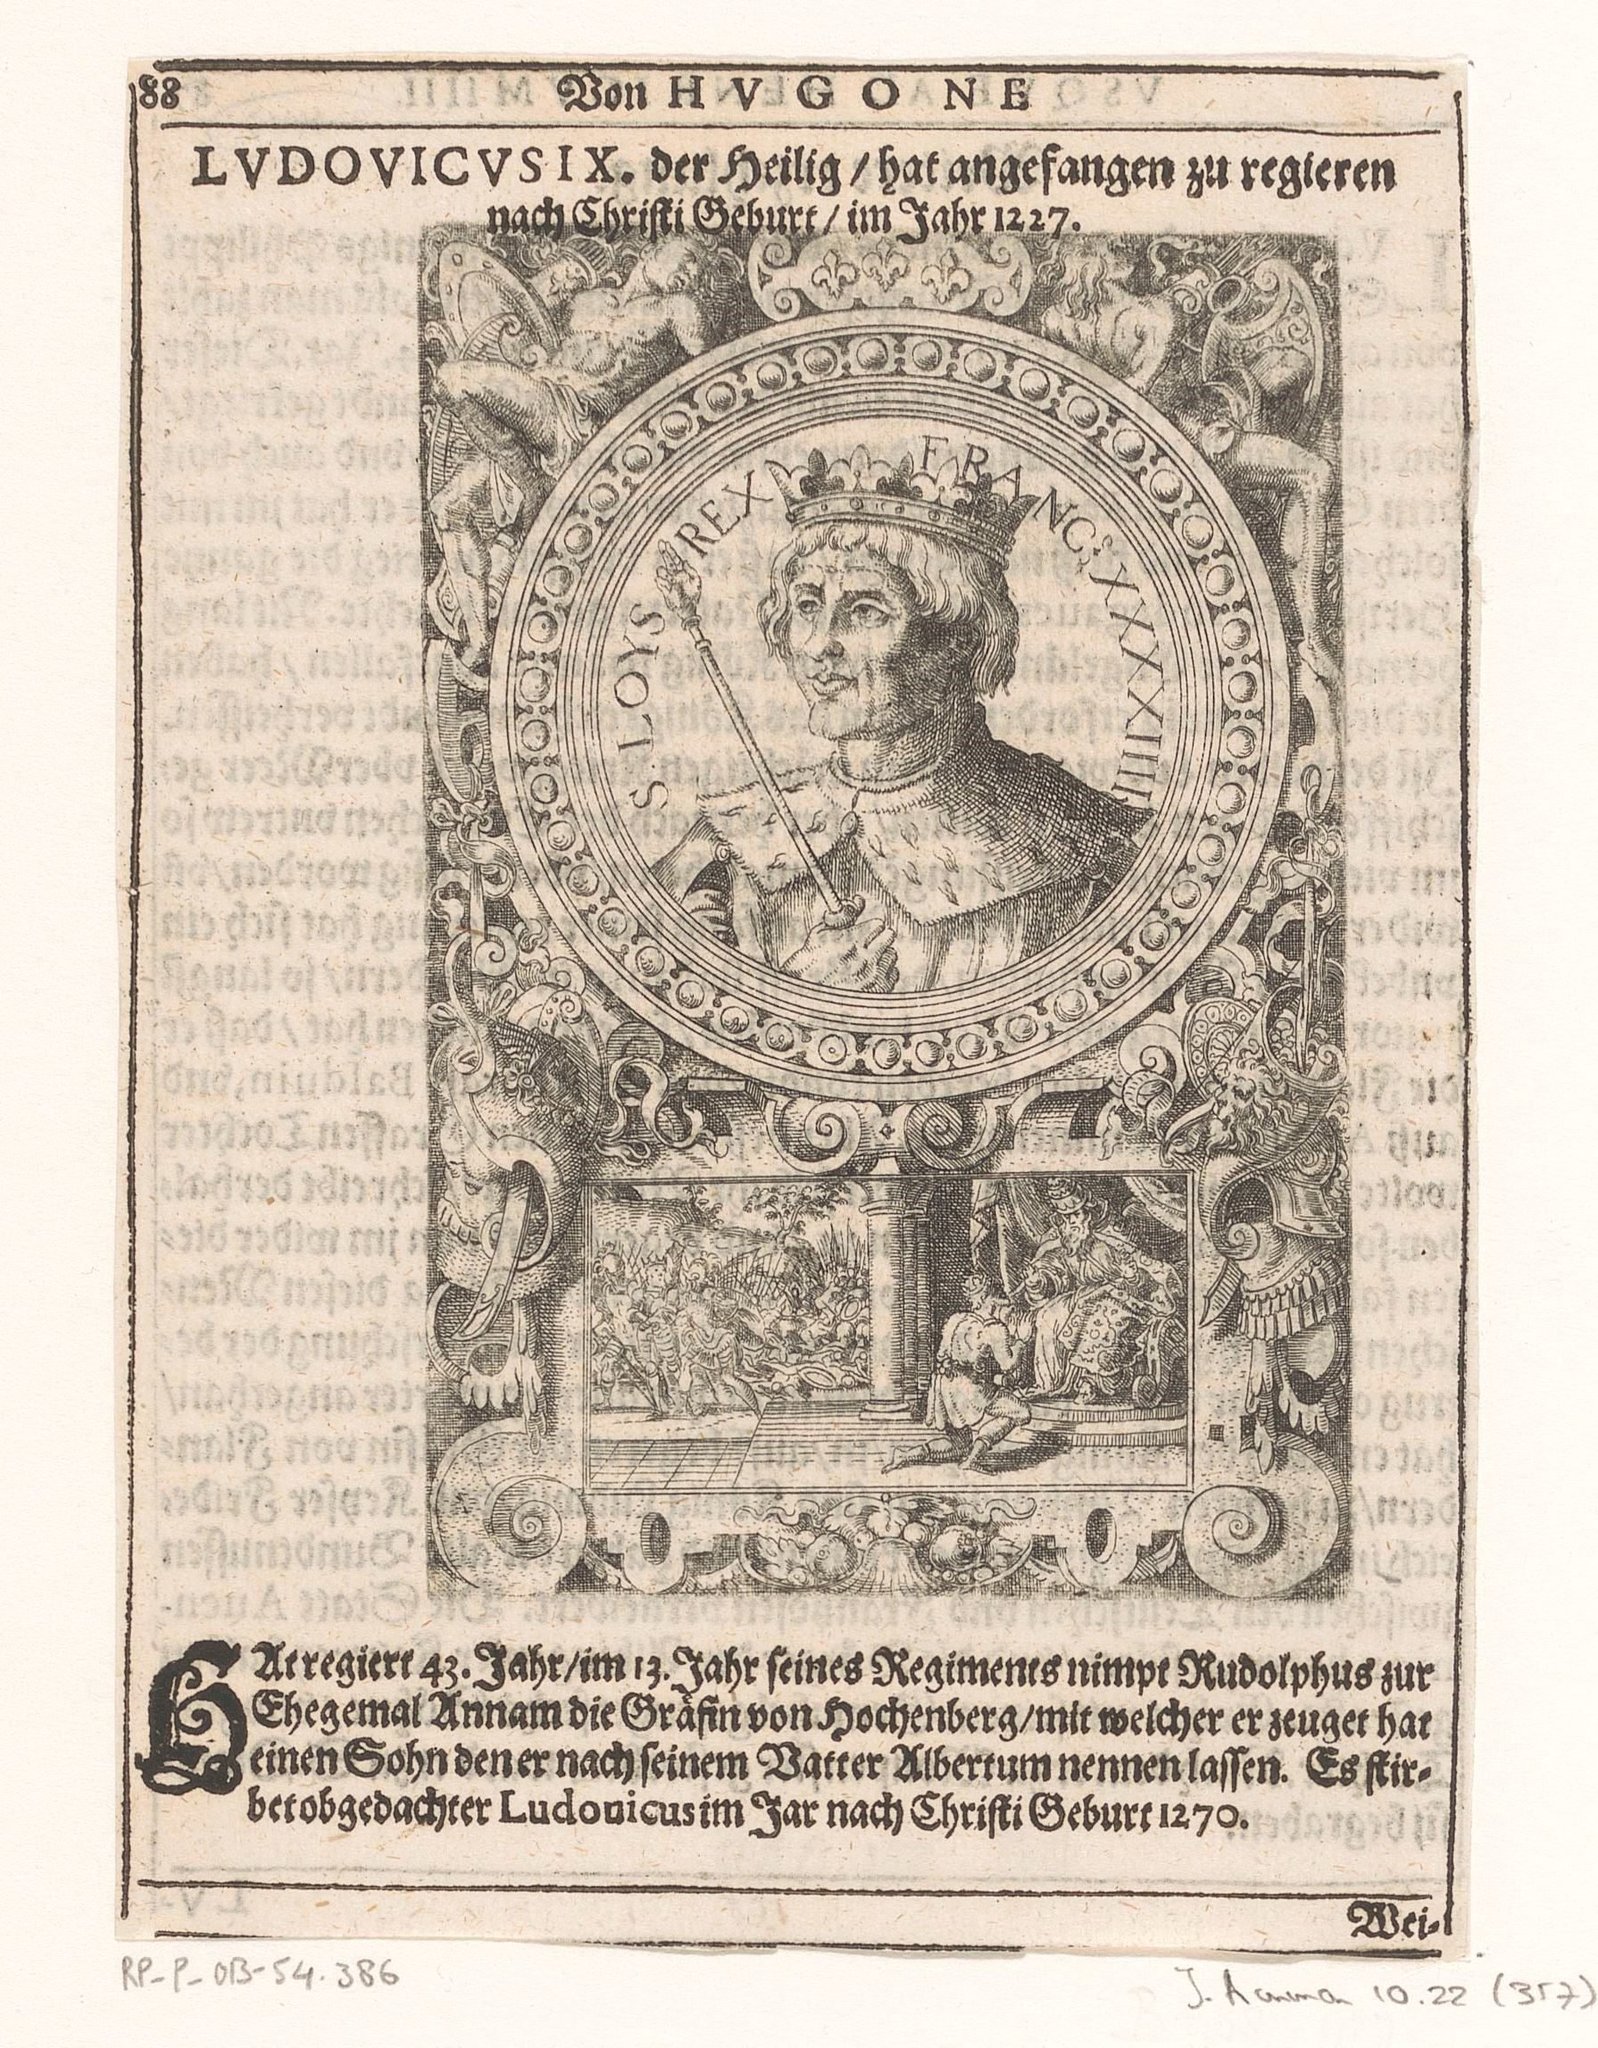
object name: print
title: Portret van Lodewijk IX de Heilige, koning van Frankrijk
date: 1598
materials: paper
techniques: etching, intaglio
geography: nuremberg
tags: scrollwork, strapwork ~ ornament, historical persons, ruler, sovereign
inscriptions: collector's mark: Lugt 2228, number: ‘158’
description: Prent afkomstig uit de publicatie: Michael Eizinger. Könige in Frankreich. Keulen: Johann Bussemacher, 1598, p. 88. De publicatie bevat prenten van Jost Amman en Virgil Solis.